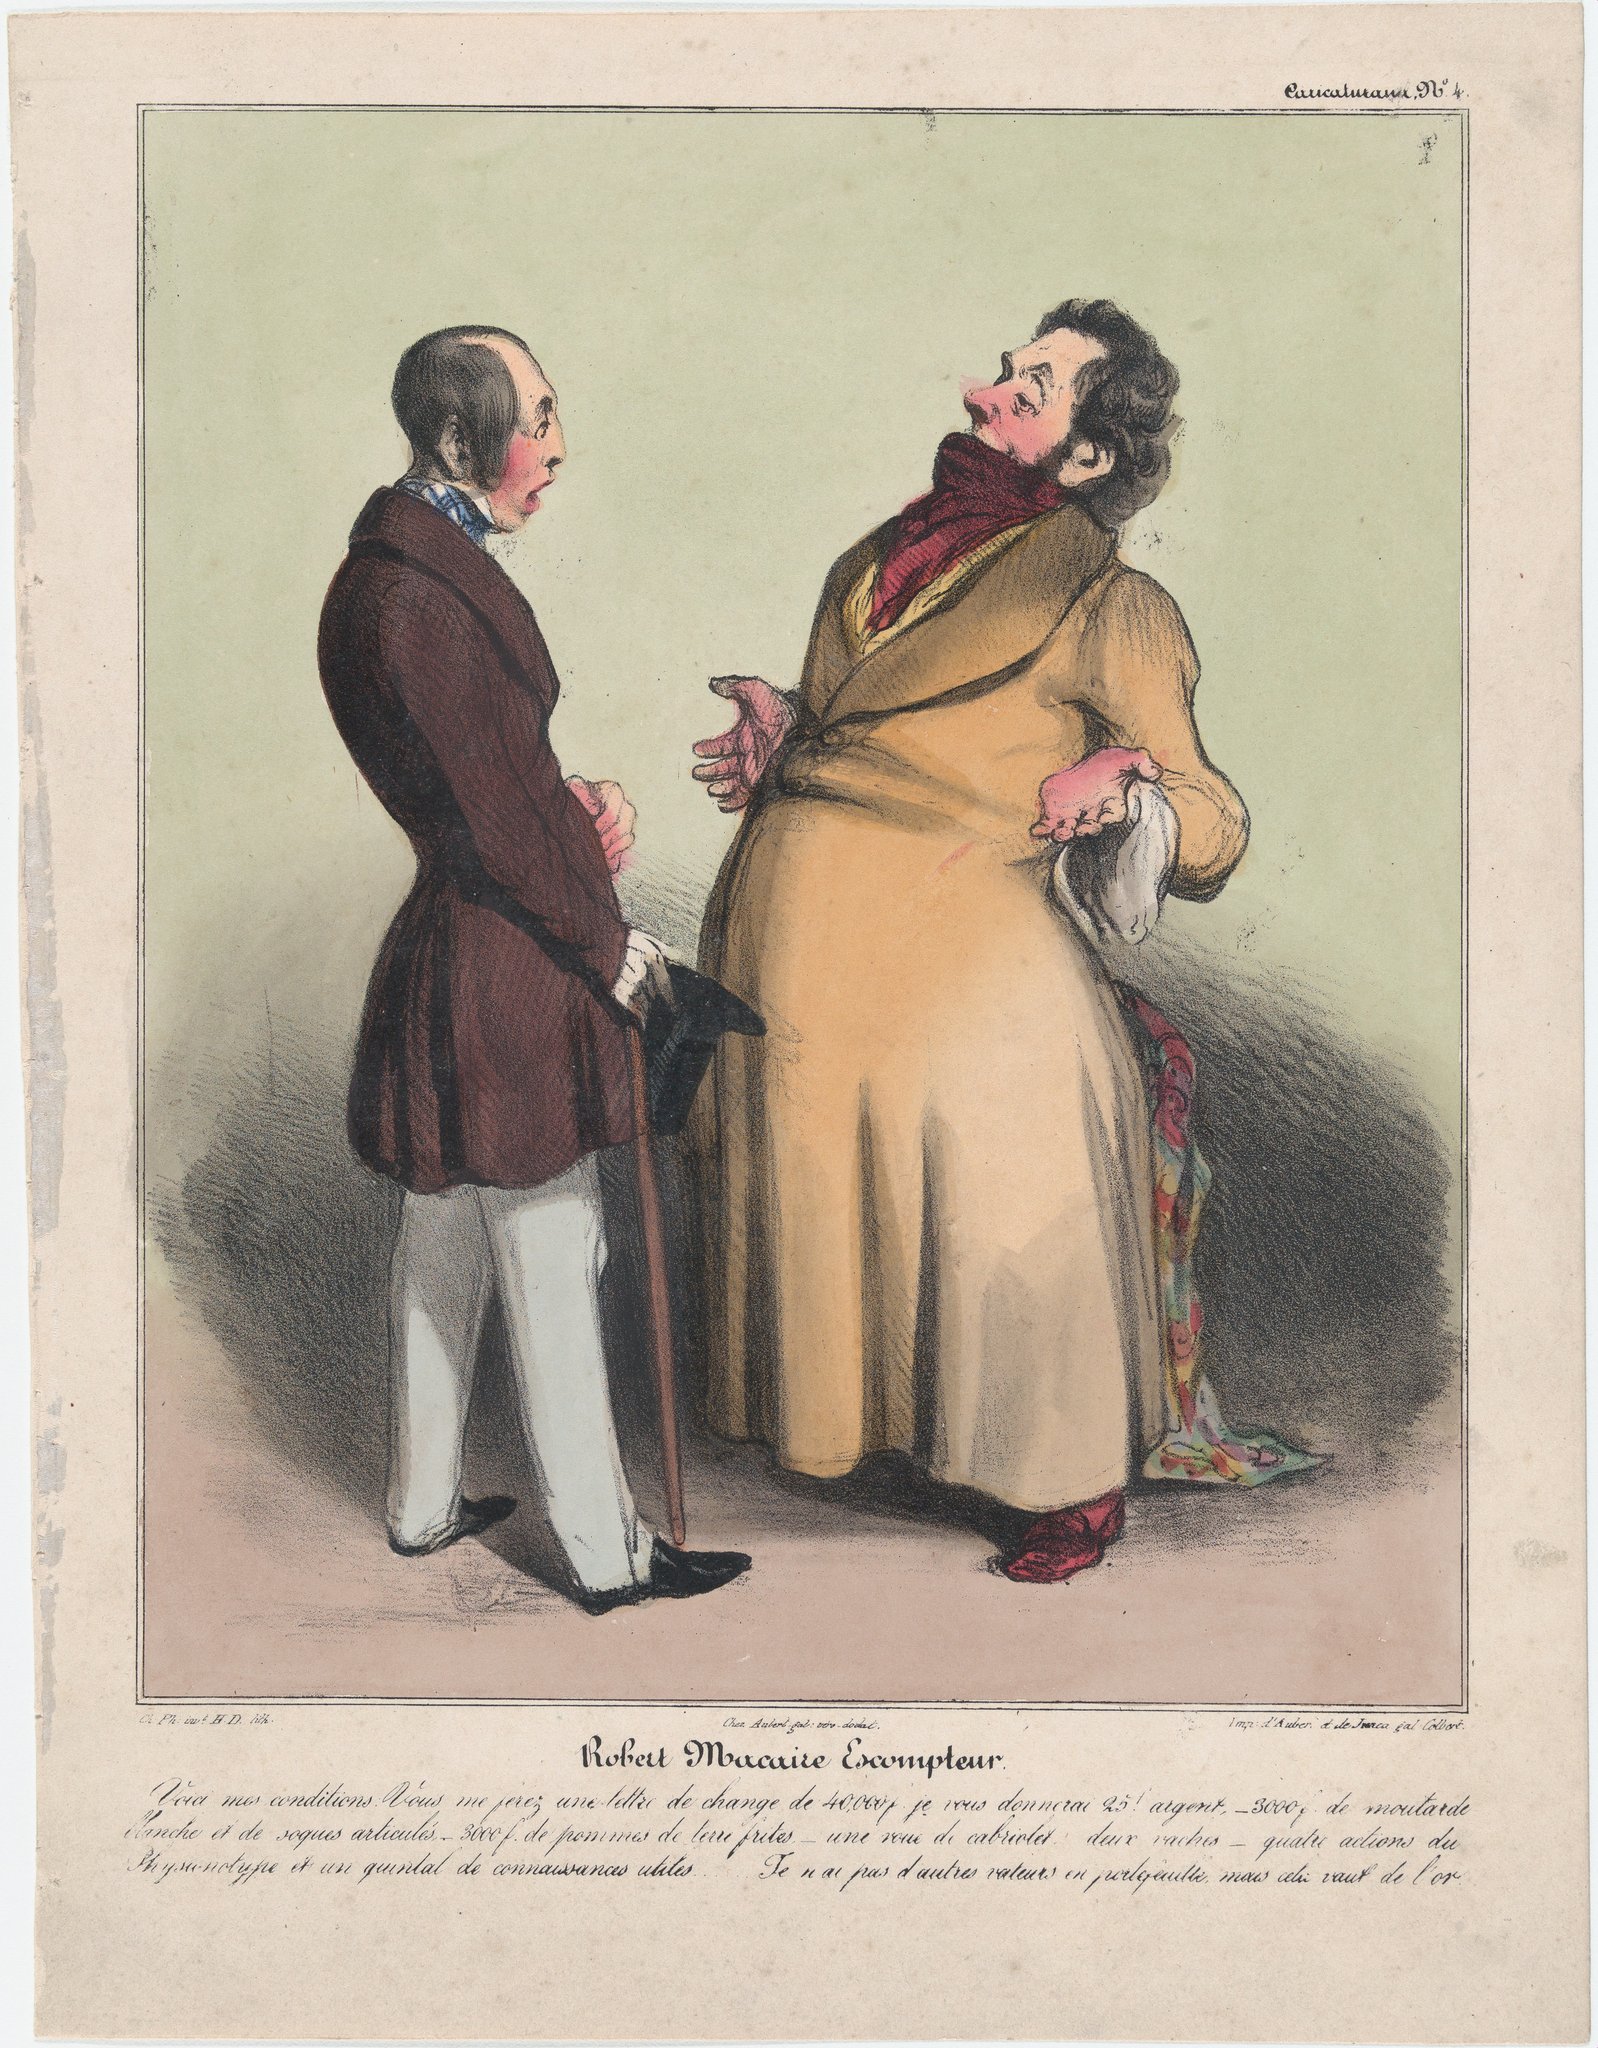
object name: print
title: Plate 4: Robert Macaire, discount broker, from 'Caricaturana,' published in Les Robert Macaires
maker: honoré daumier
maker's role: artist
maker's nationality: french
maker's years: 1808-1879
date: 1838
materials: paper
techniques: lithograph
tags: men